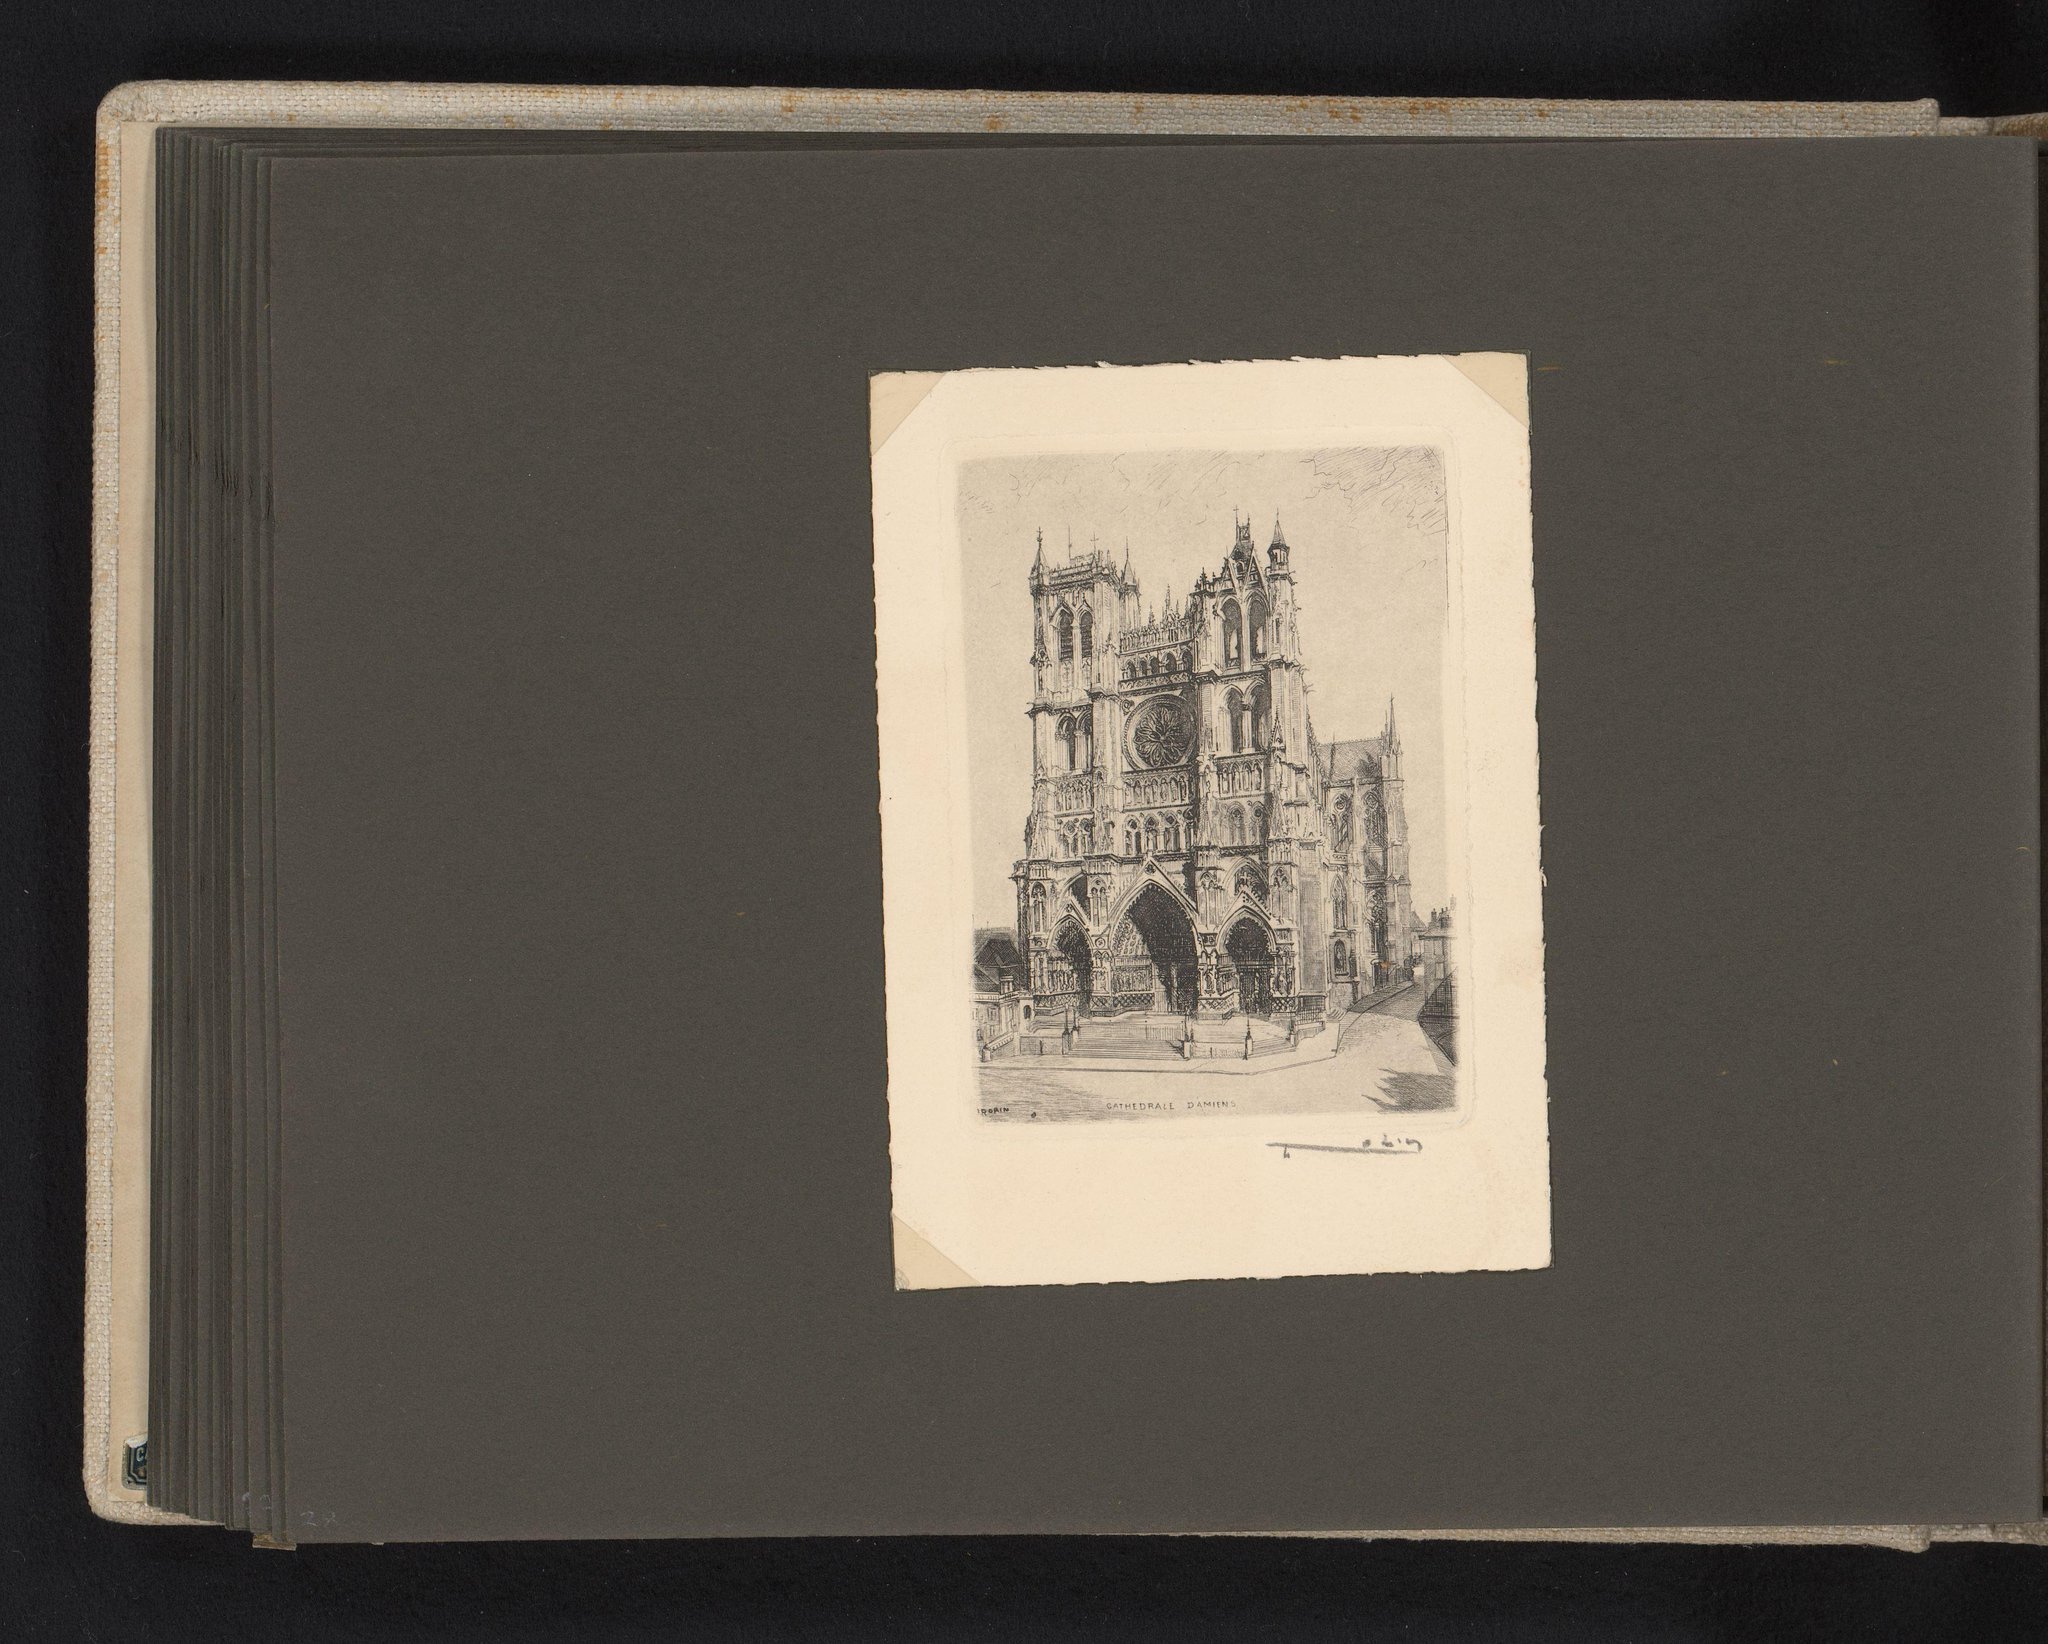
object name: album leaf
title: Kathedraal van Amiens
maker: léopold robin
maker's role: print maker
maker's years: 1877-1939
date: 1930-1939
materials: cardboard, paper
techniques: etching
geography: france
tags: church (exterior), notre-dame d'amiens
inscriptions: inscription: ‘... 19/VI 1940 ...’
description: Albumblad met een ets van de kathedraal van Amiens. Onderdeel van de fotoalbum van de Wehrmacht 1938-1941.